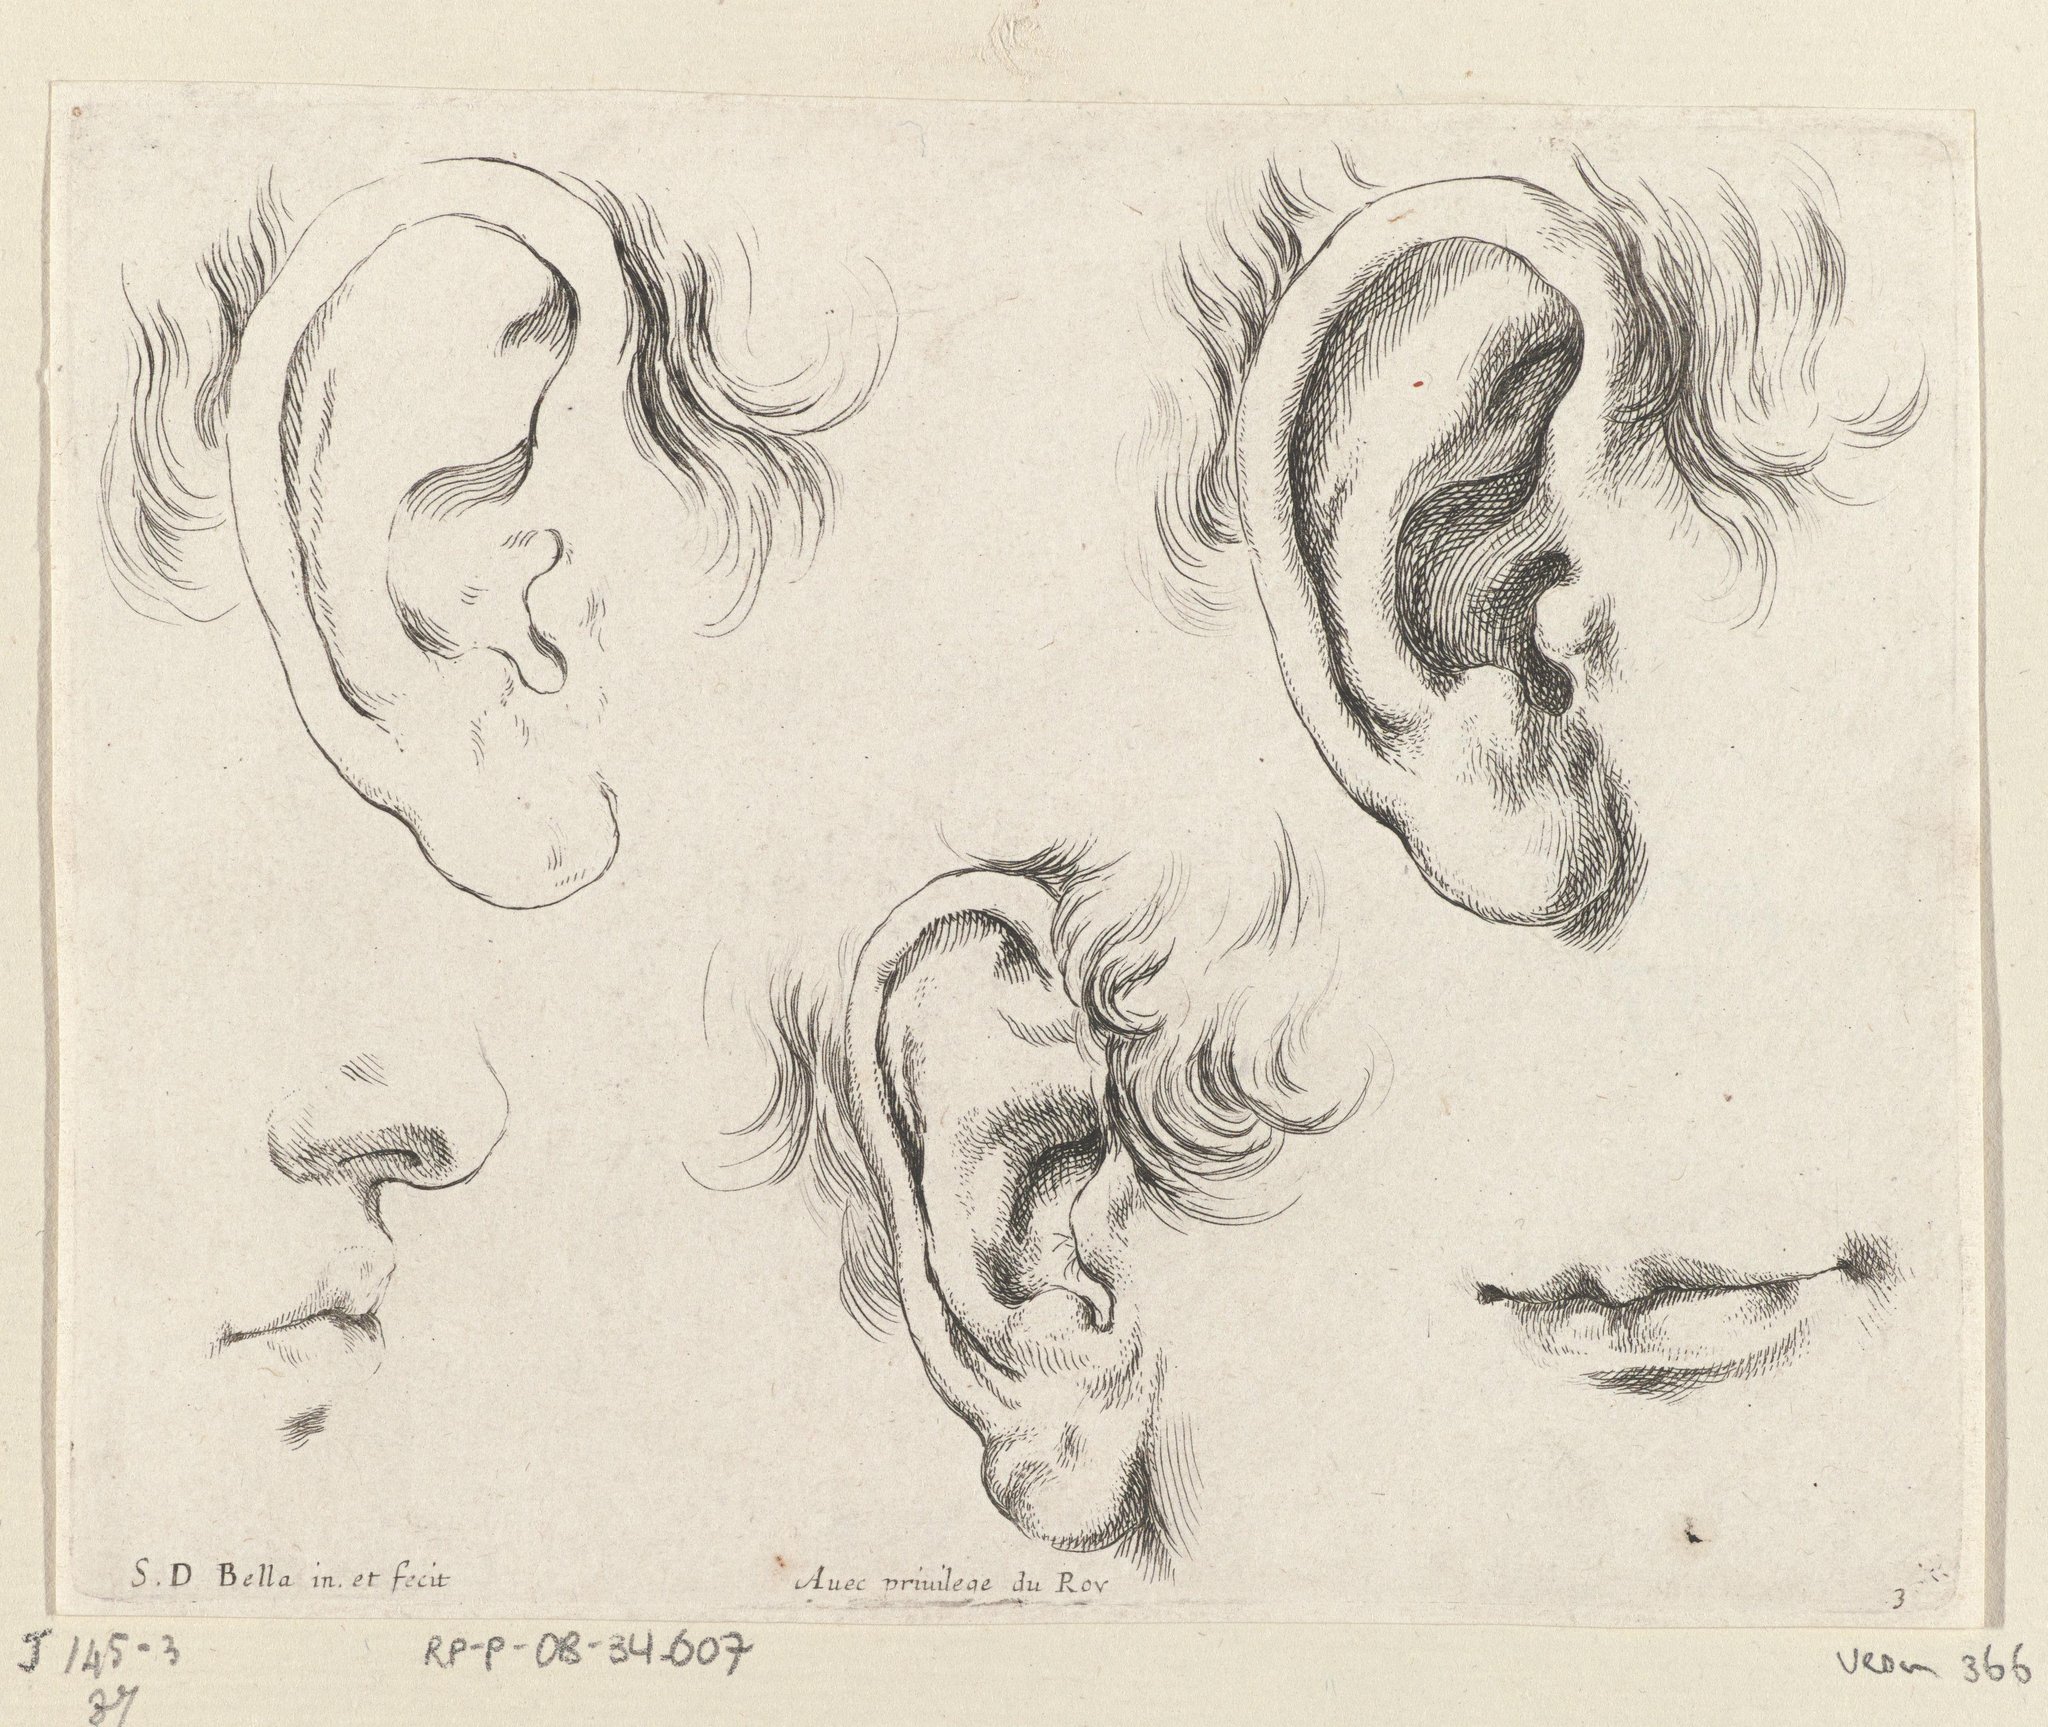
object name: print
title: De beginselen van het tekenen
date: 1620-1664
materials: paper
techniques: etching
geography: france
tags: ears, parts of the face: nose, mouth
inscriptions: collector's mark: Lugt 240